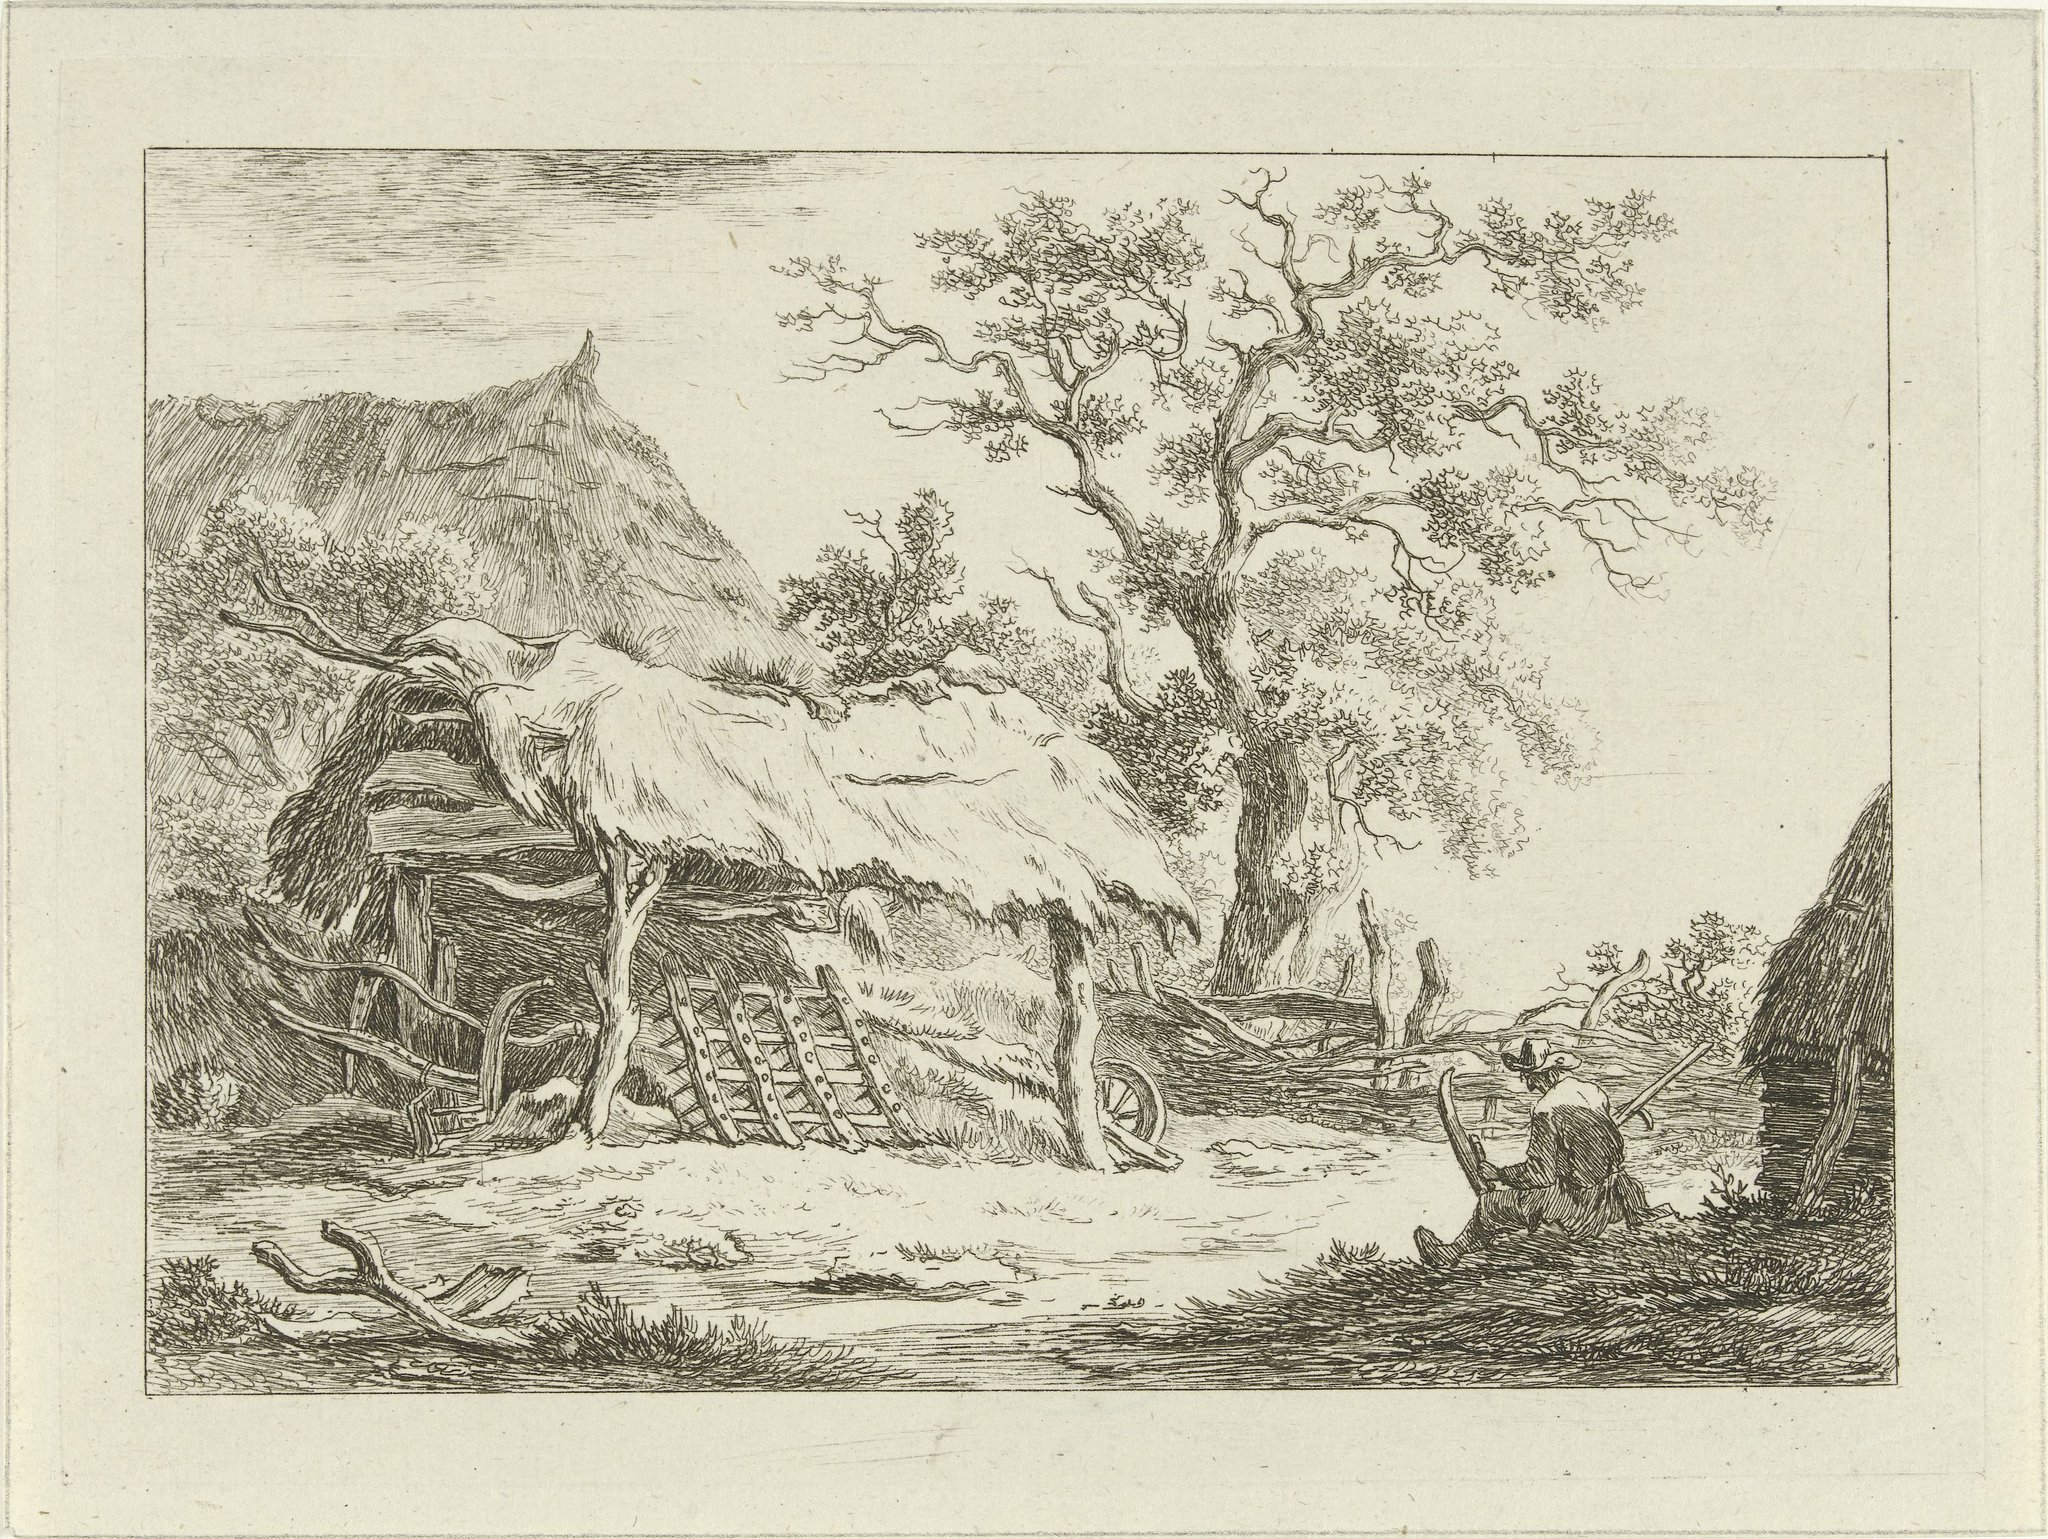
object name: print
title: Landschappen (1-6)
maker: carel lodewijk hansen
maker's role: draughtsman, painter, print maker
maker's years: 1765-1840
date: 1780-1840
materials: paper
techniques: etching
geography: netherlands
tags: barn, farm or solitary house in landscape (+ city(-scape) with figures, staffage), agricultural implements: harrow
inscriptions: collector's mark: Lugt 2228